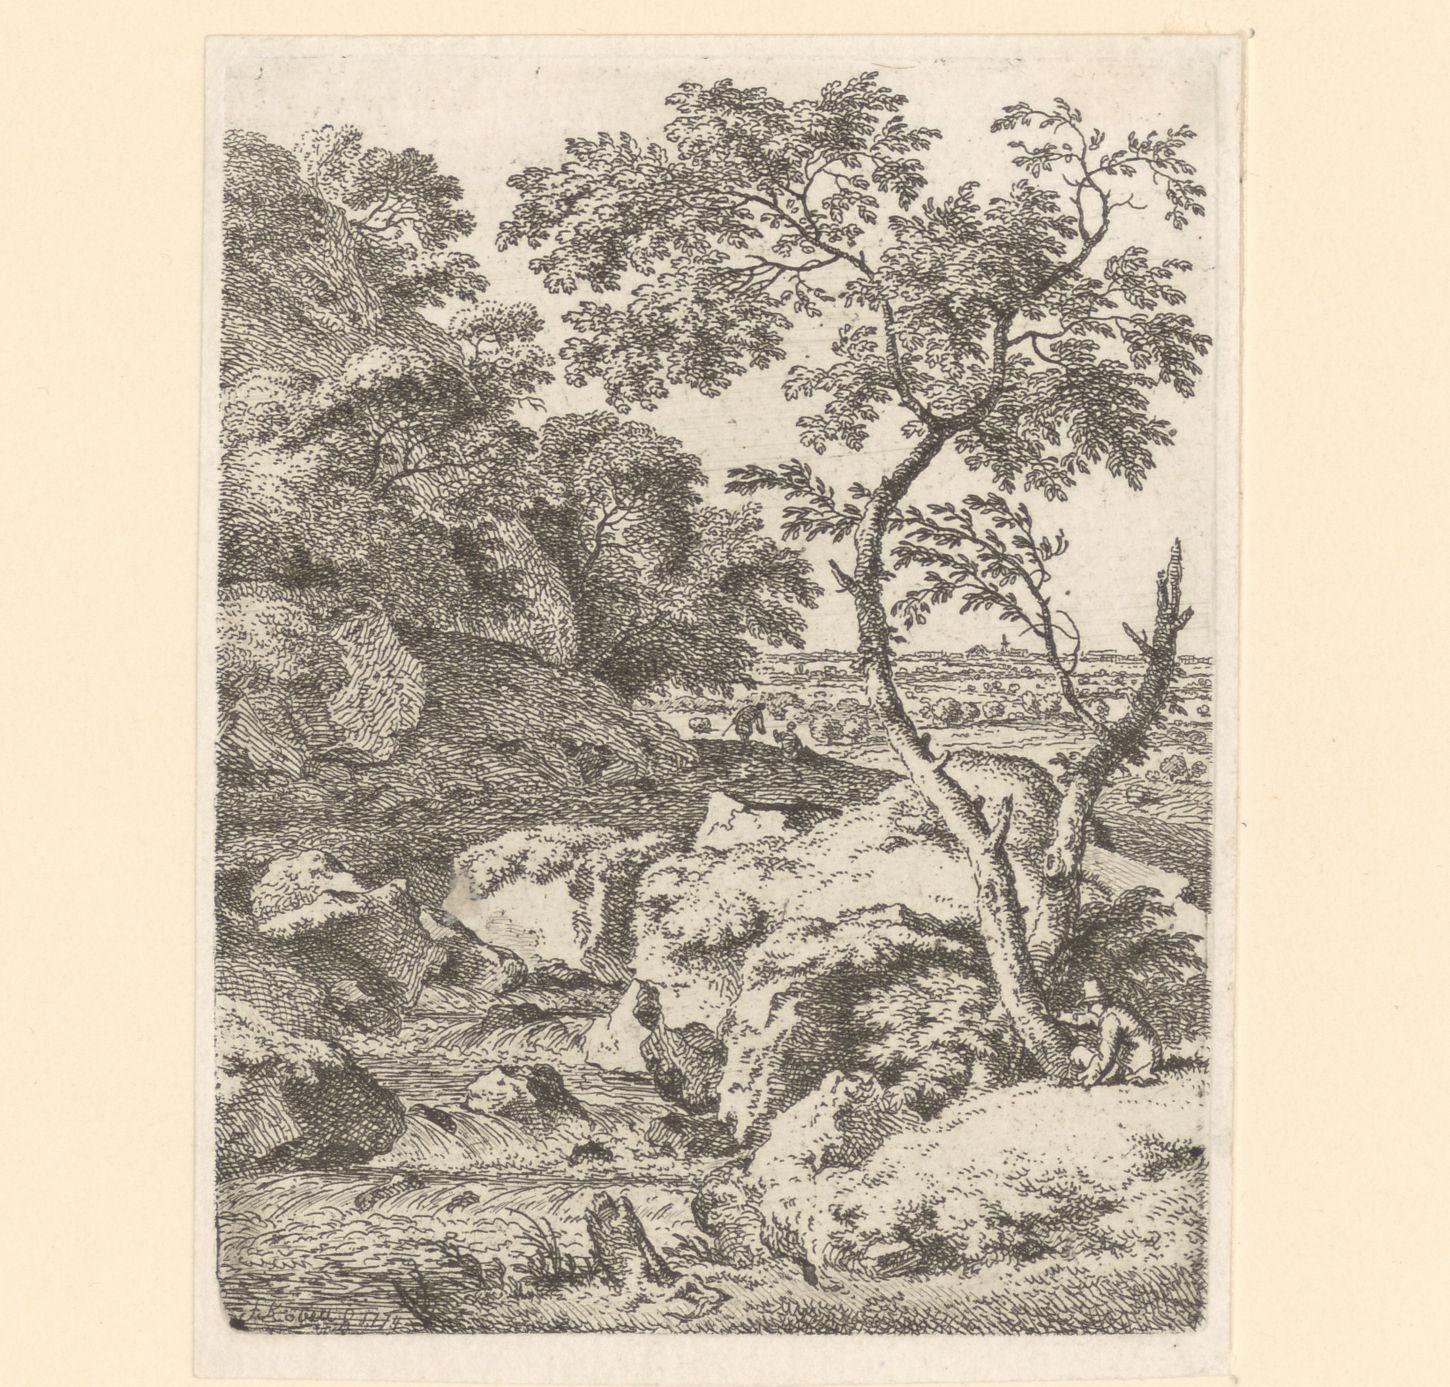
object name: print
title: Heuvellandschap met een beek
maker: ferdinand kobell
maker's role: artist, painter, print maker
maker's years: 1740-1799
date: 1774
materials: paper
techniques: etching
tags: (traveller) resting in the open air, (high) hill, brook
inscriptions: date